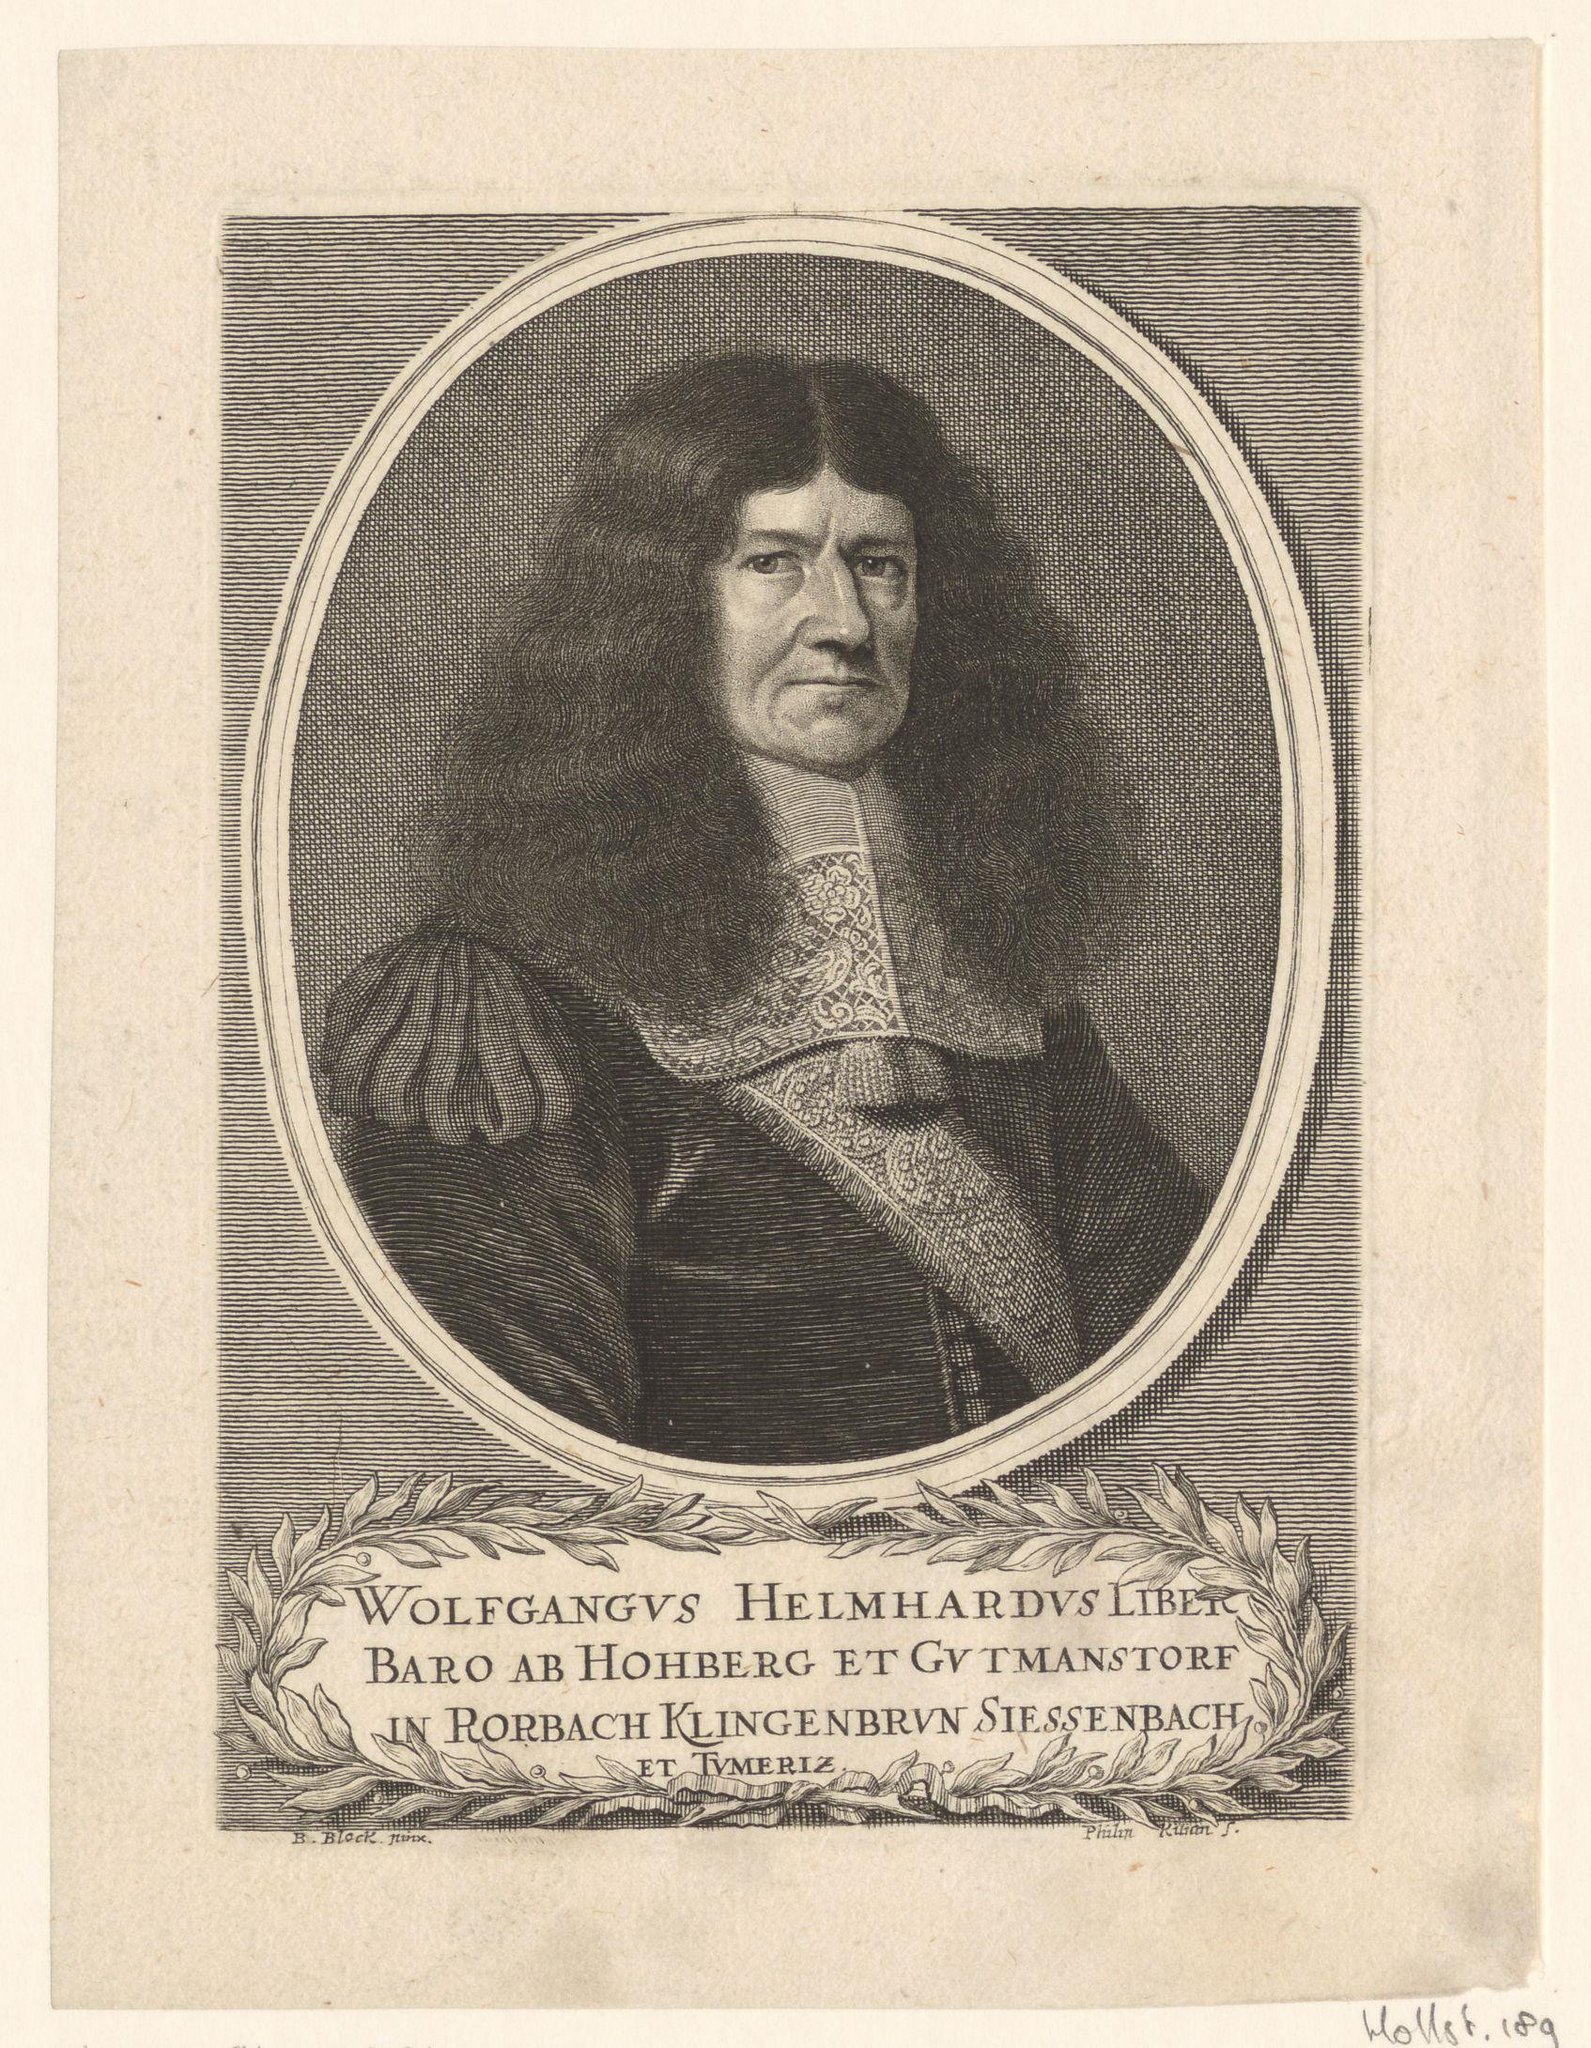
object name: print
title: Portret van Wolf Helmhard von Hohberg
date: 1641-1693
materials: paper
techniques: engraving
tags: historical persons, writer, poet, author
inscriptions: collector's mark: Lugt 2228